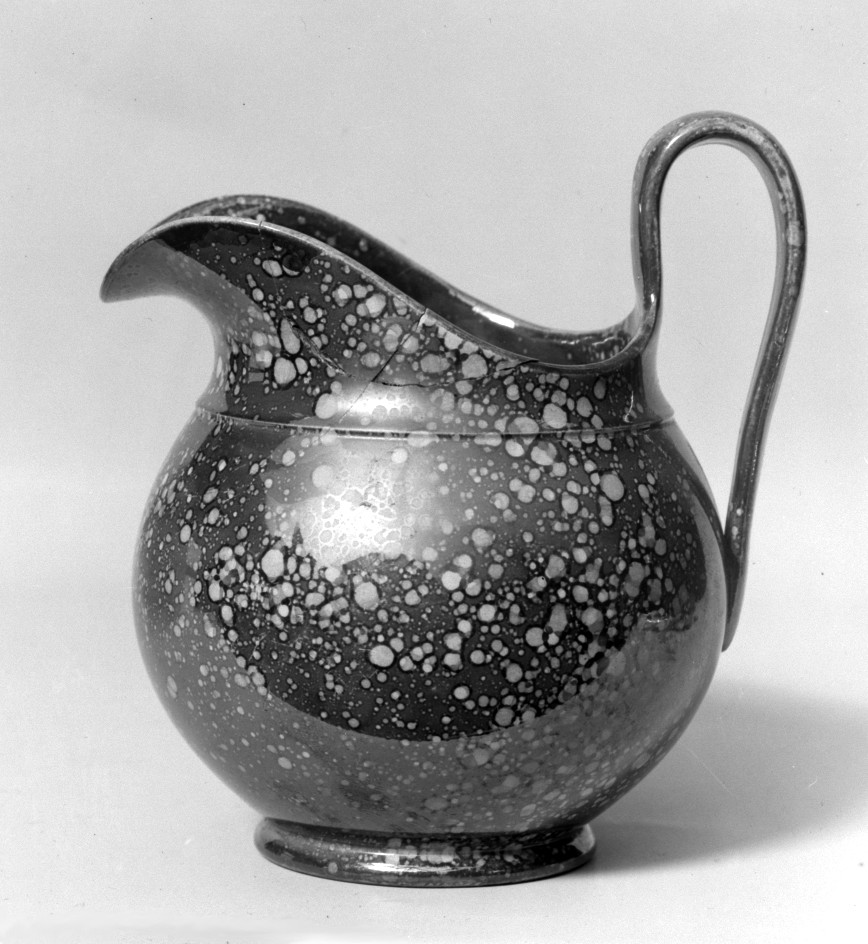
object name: creamer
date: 1820-1830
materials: pottery